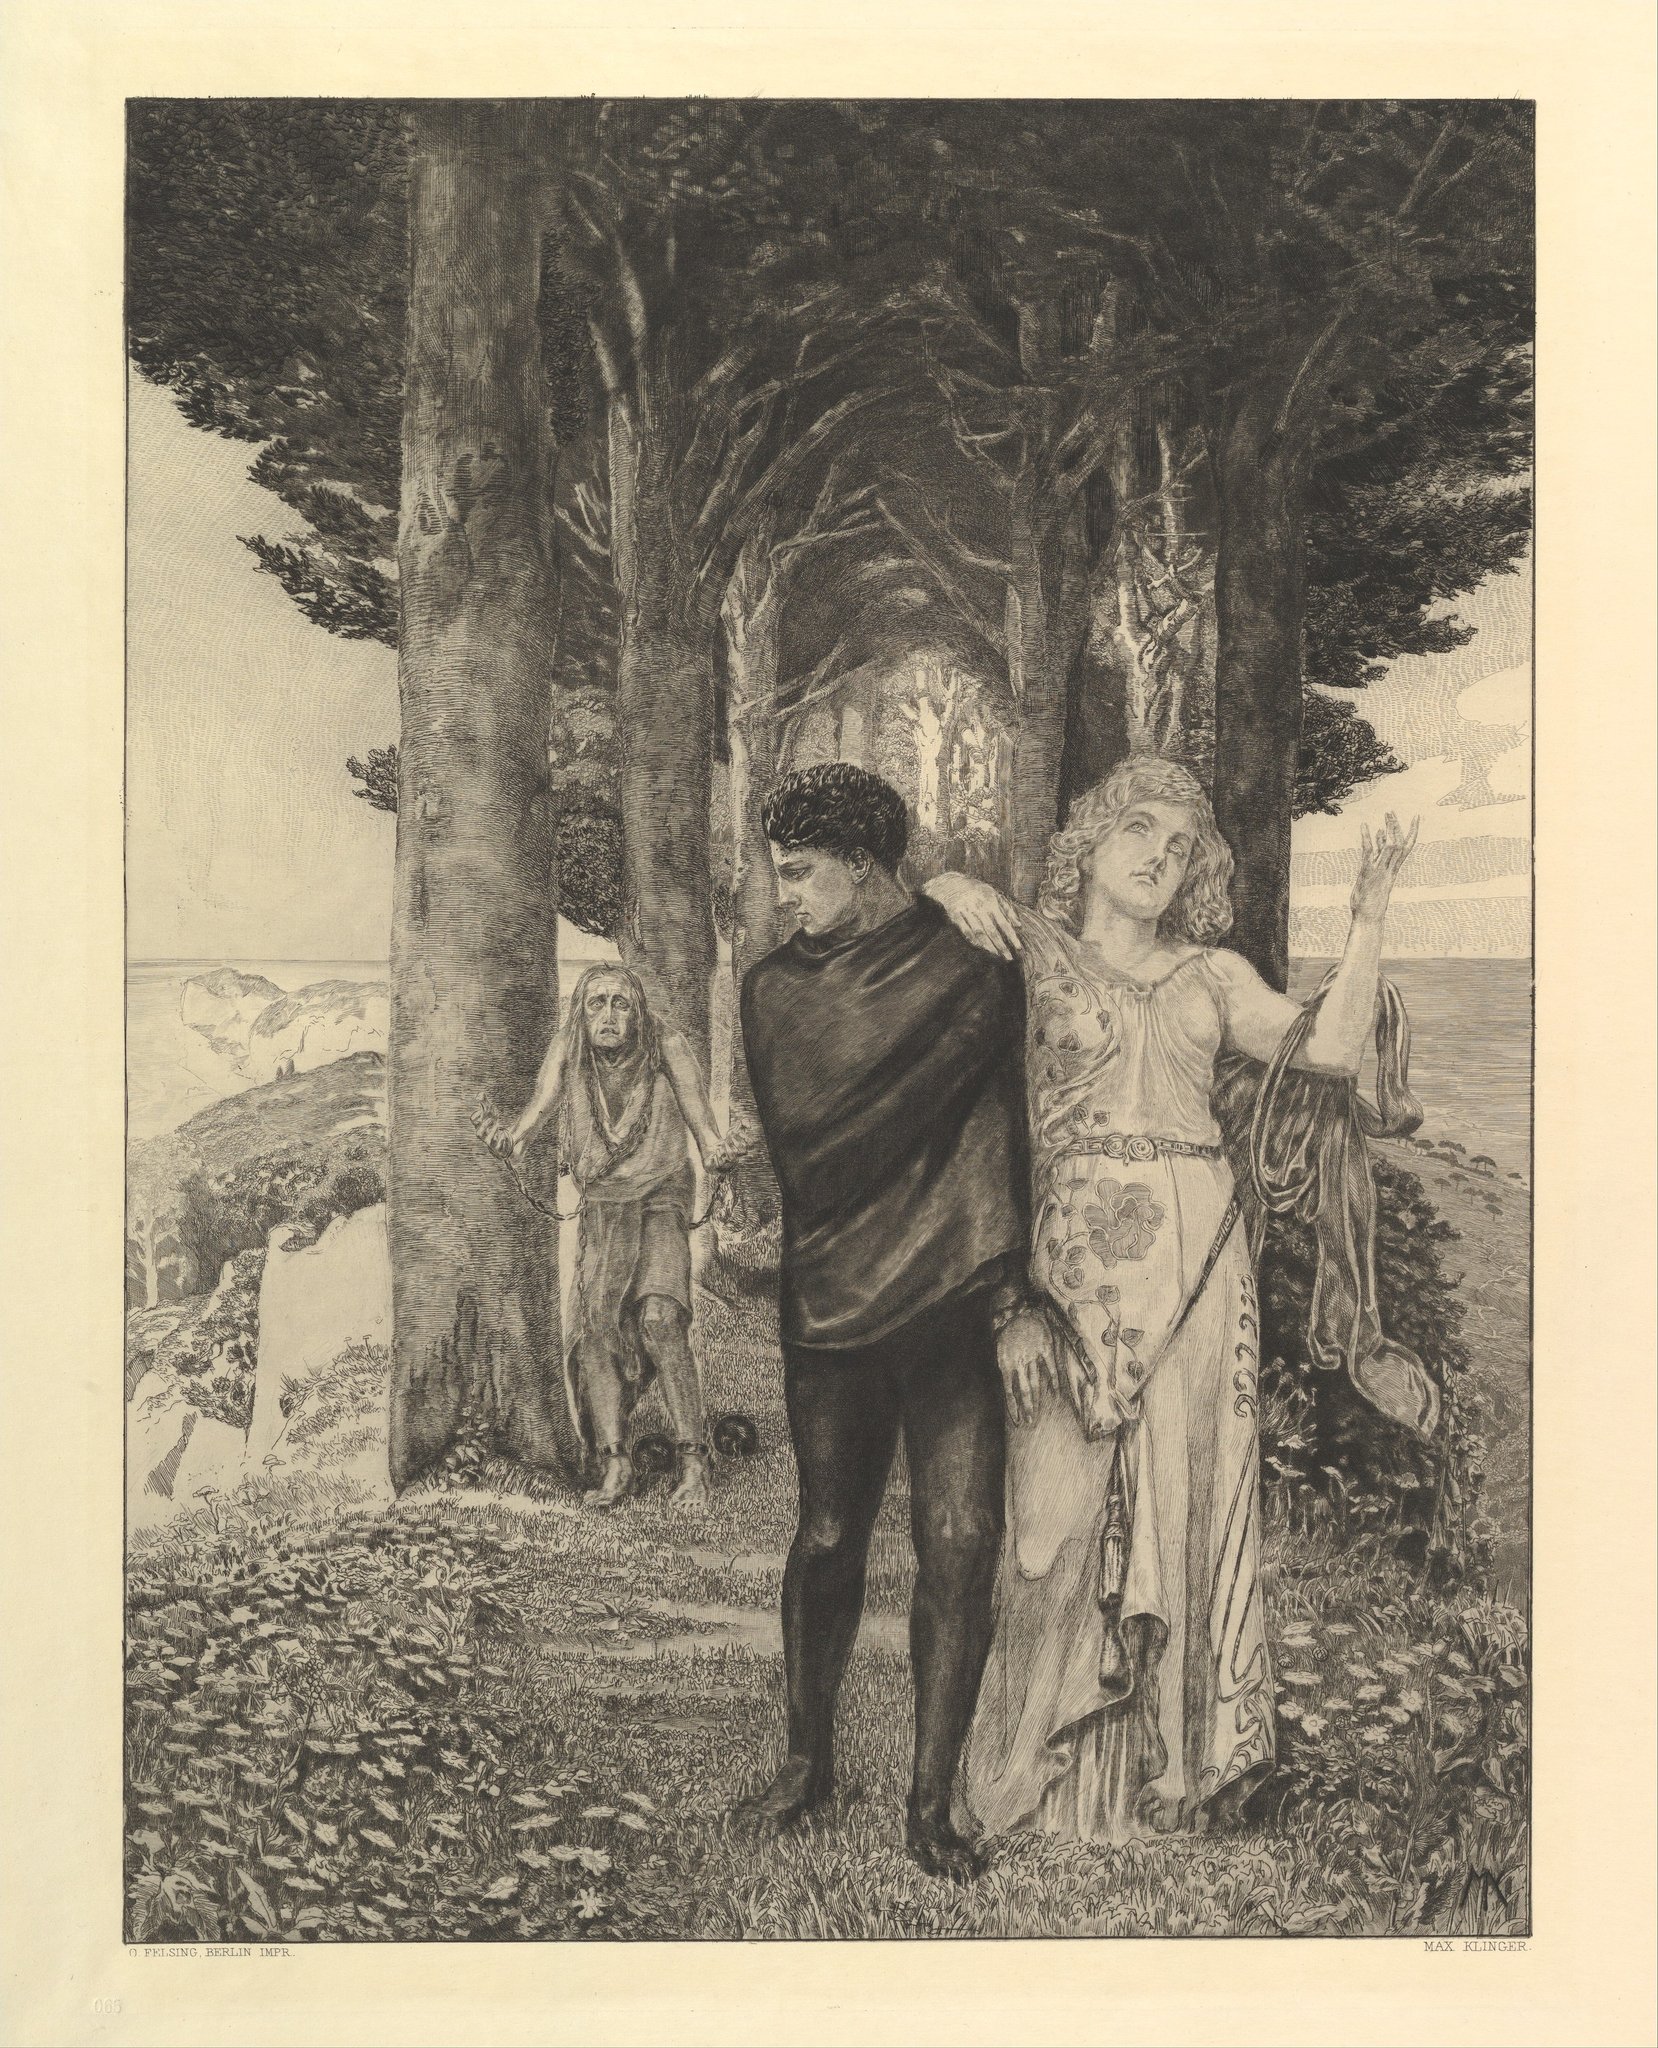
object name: print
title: Genie (Künstler), from the series Vom Tode Zweiter Teil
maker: max klinger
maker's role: artist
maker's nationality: german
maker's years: 1857-1920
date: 1910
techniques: aquatint, etching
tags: men,women,trees